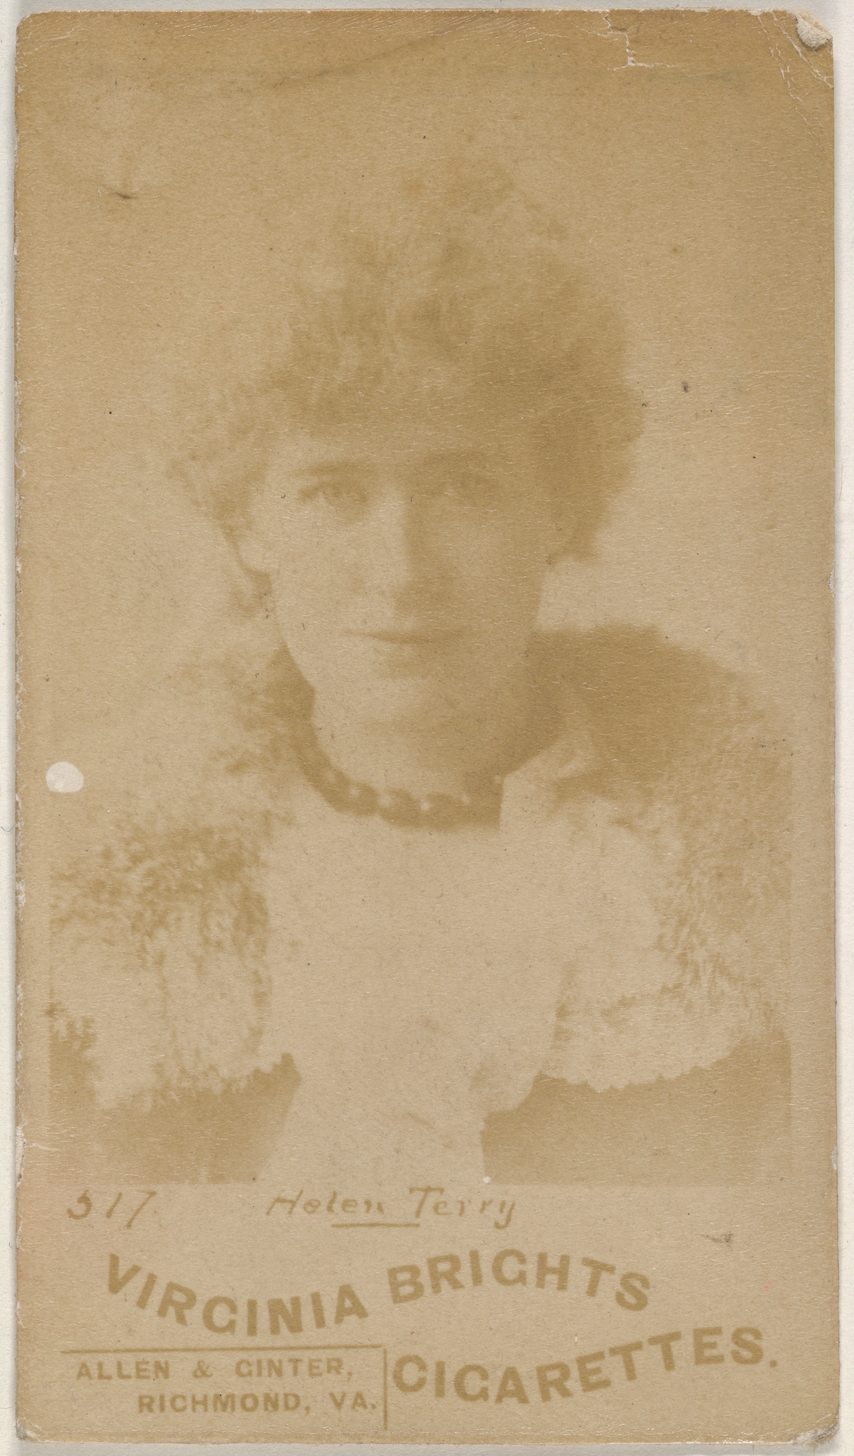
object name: photograph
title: Card 517, Helen Terry, from the Actors and Actresses series (N45, Type 6) for Virginia Brights Cigarettes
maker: allen & ginter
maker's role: publisher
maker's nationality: american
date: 1888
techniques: albumen silver print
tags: portraits,women,actresses